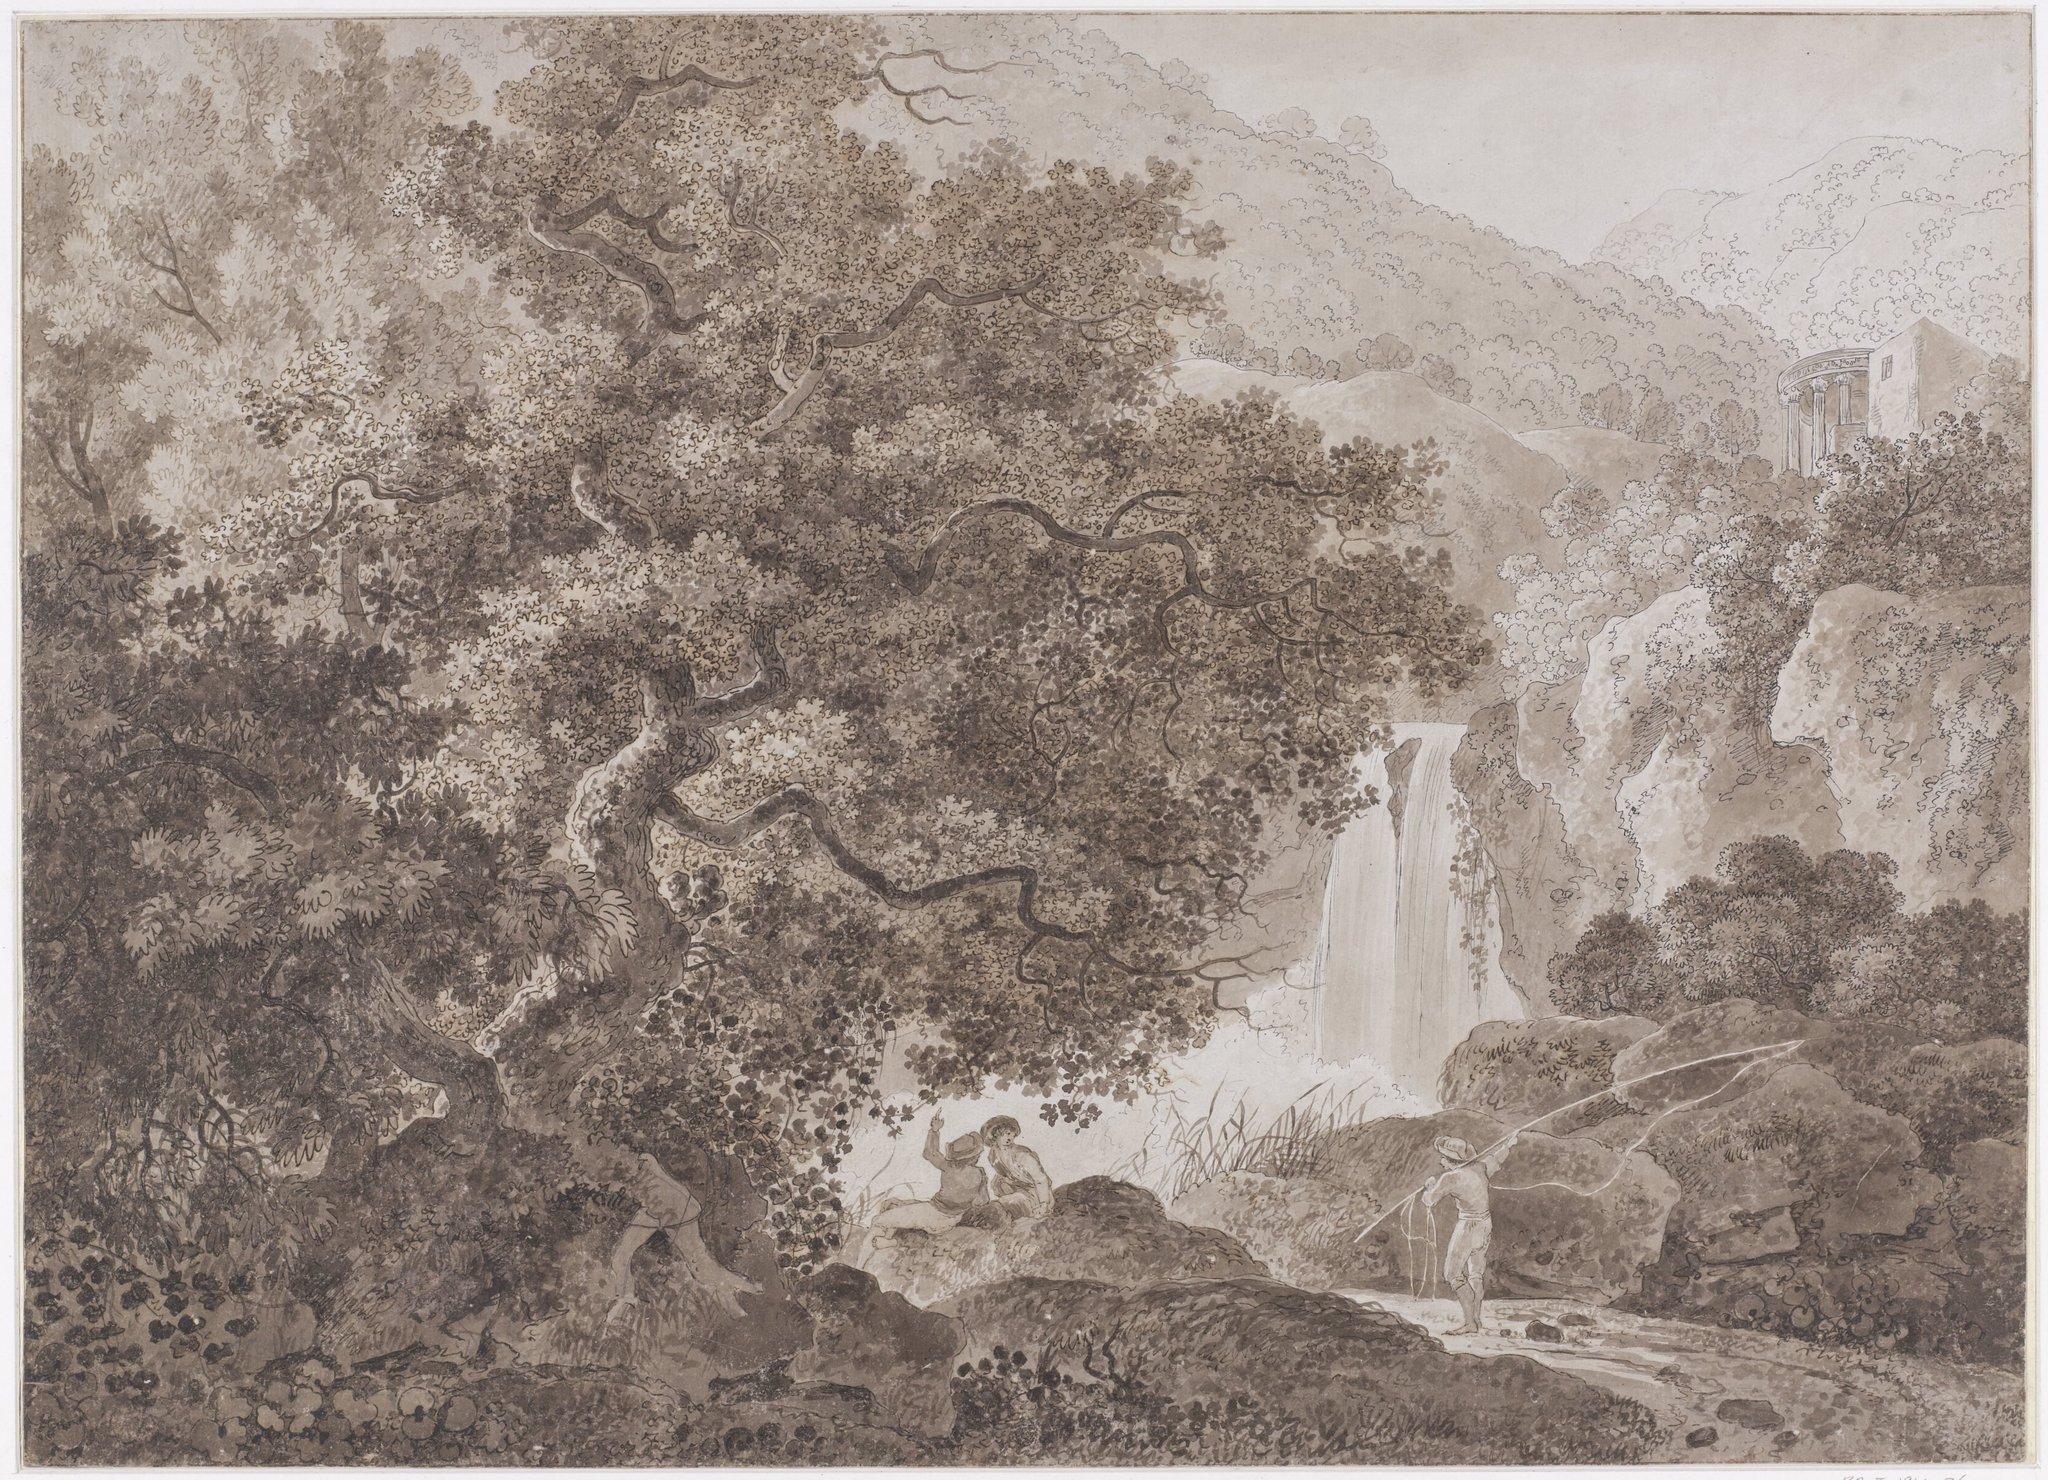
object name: drawing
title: Bebost berglandschap (Tivoli)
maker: johann conrad steiner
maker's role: draughtsman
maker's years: 1757-1818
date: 1767-1818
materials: ink, paper, pencil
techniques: brush, pen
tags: waterfall, forest, wood, tivoli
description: Bebost berglandschap (Tivoli). Links, onder een knoestige eik, zitten twee jongelingen bij een waterval op een rotsblok. Van rechts nadert door de bedding van een beek een hengelaar met de hengel over de schouder. Rechts boven: rond tempeltje van Vesta.